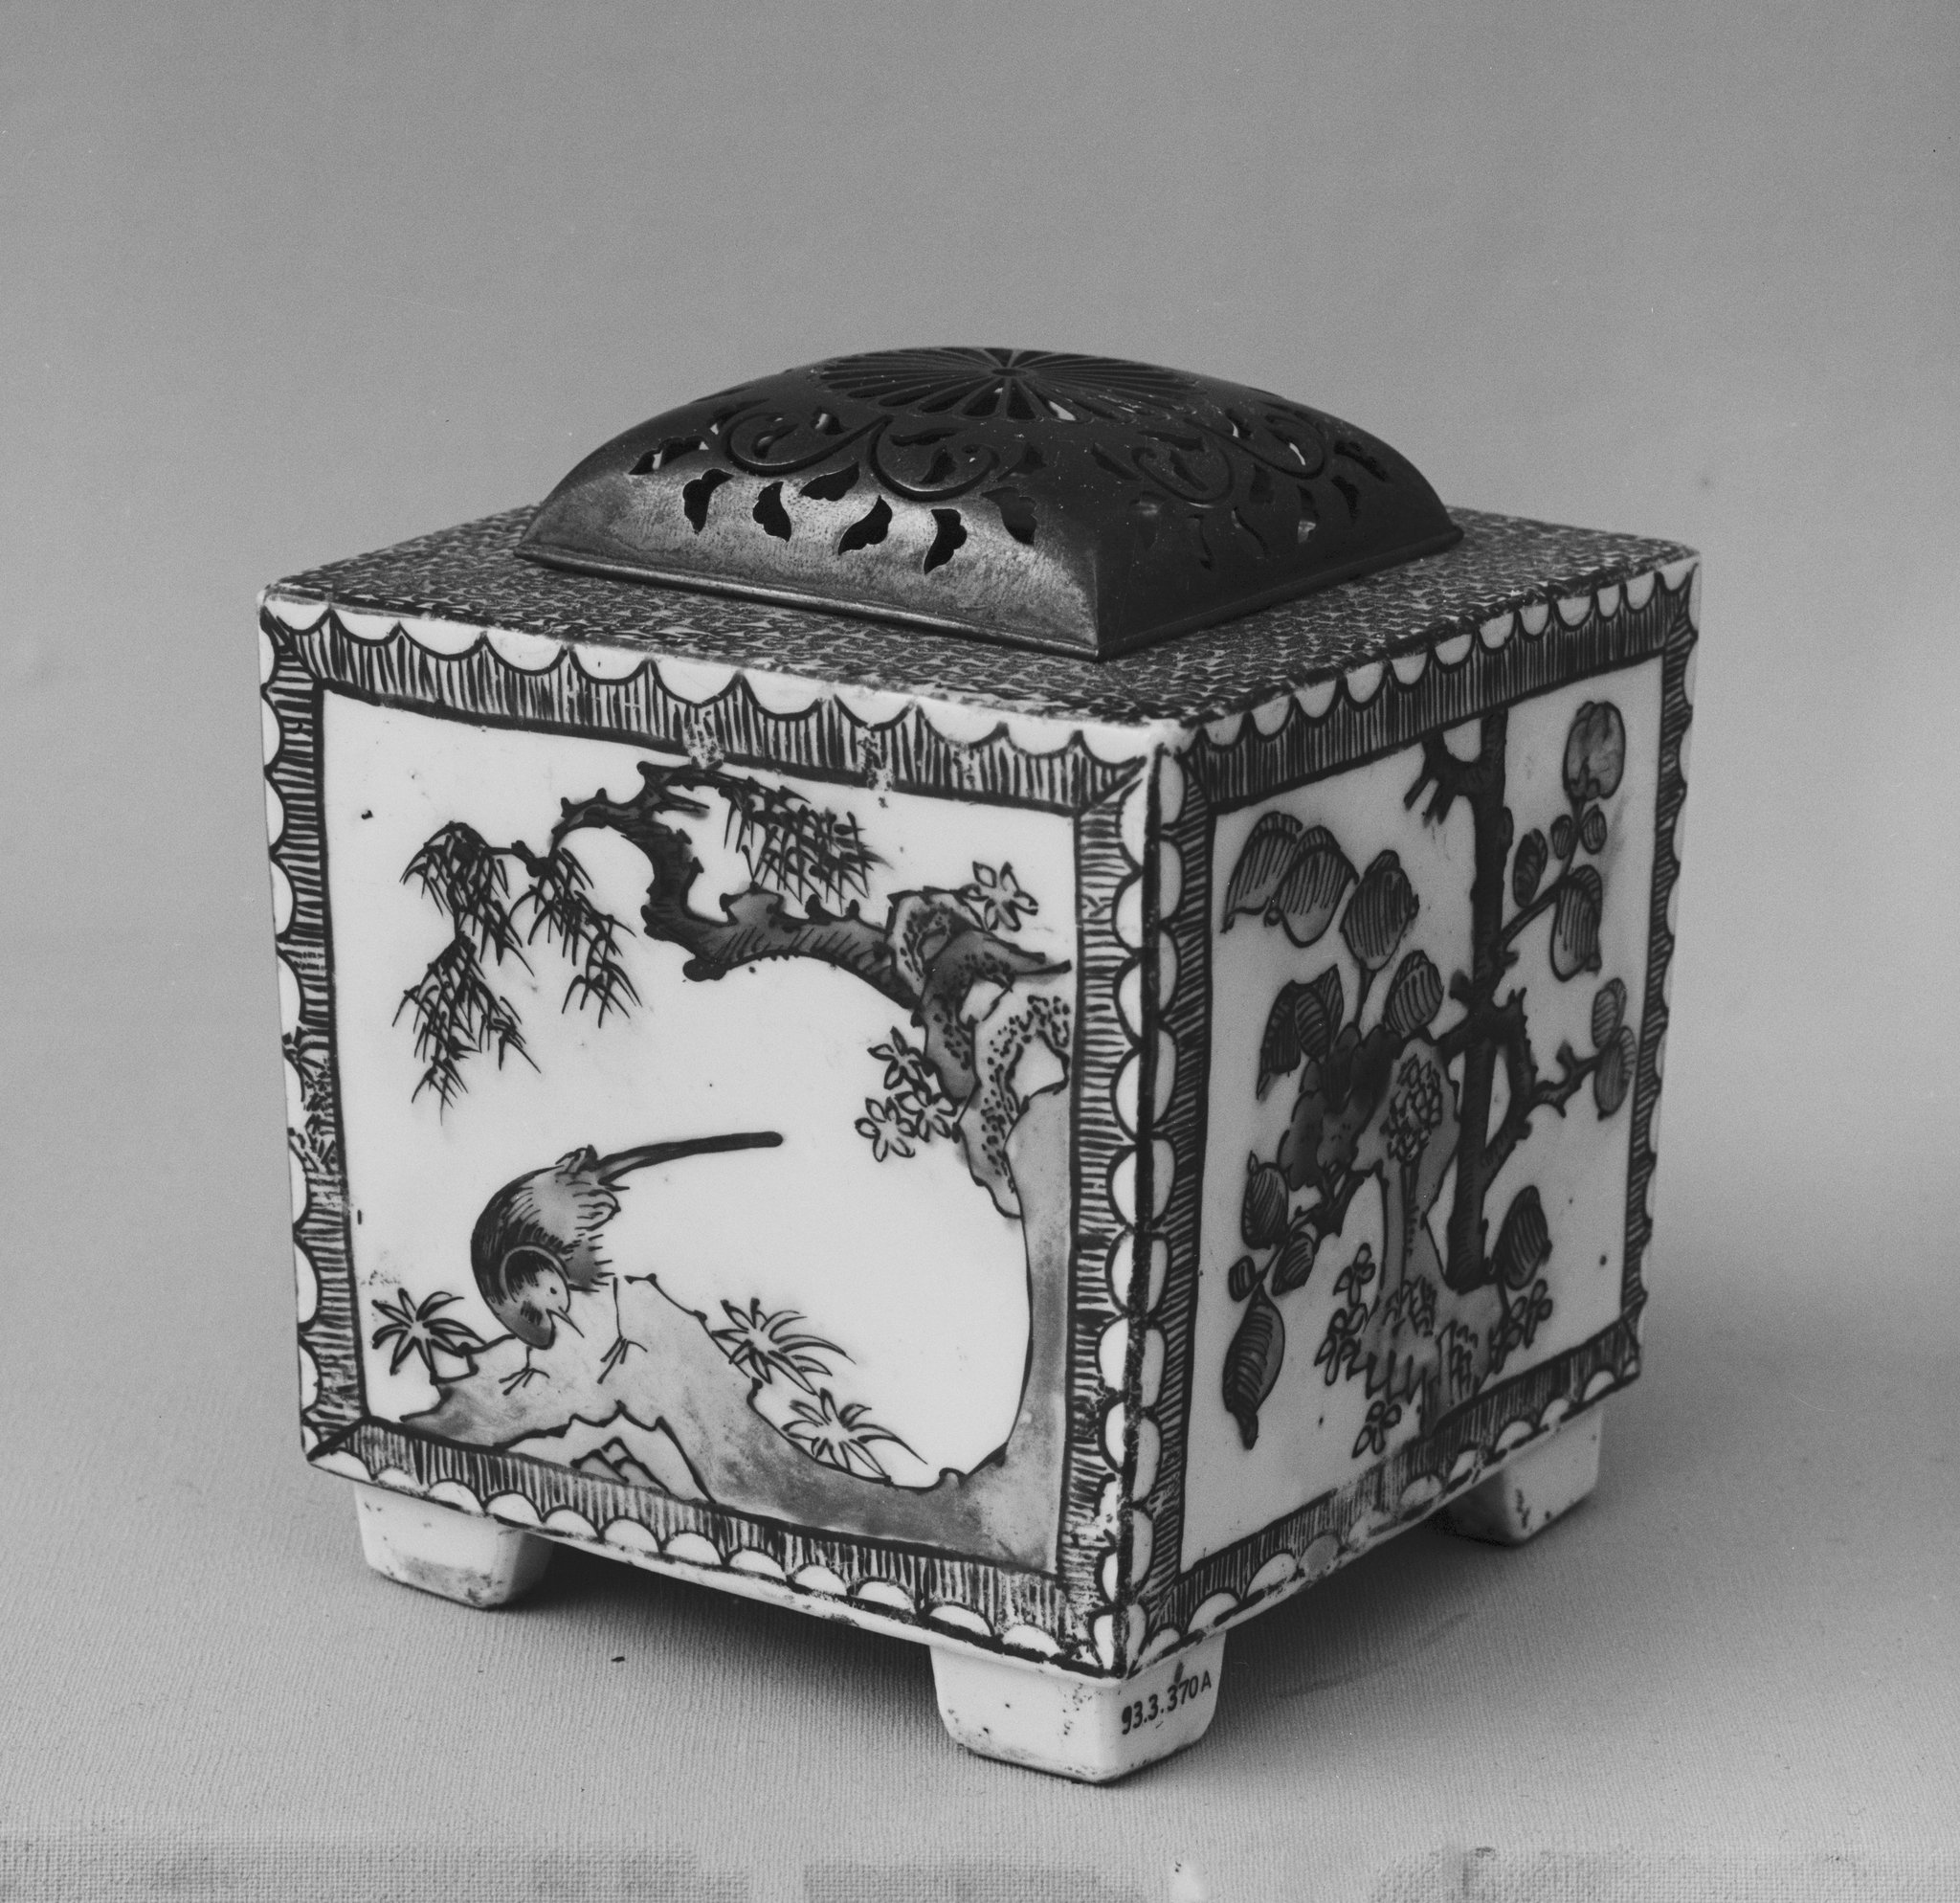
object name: incense burner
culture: japanese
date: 1700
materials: enamel, glaze, porcelain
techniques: polychrome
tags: birds,trees